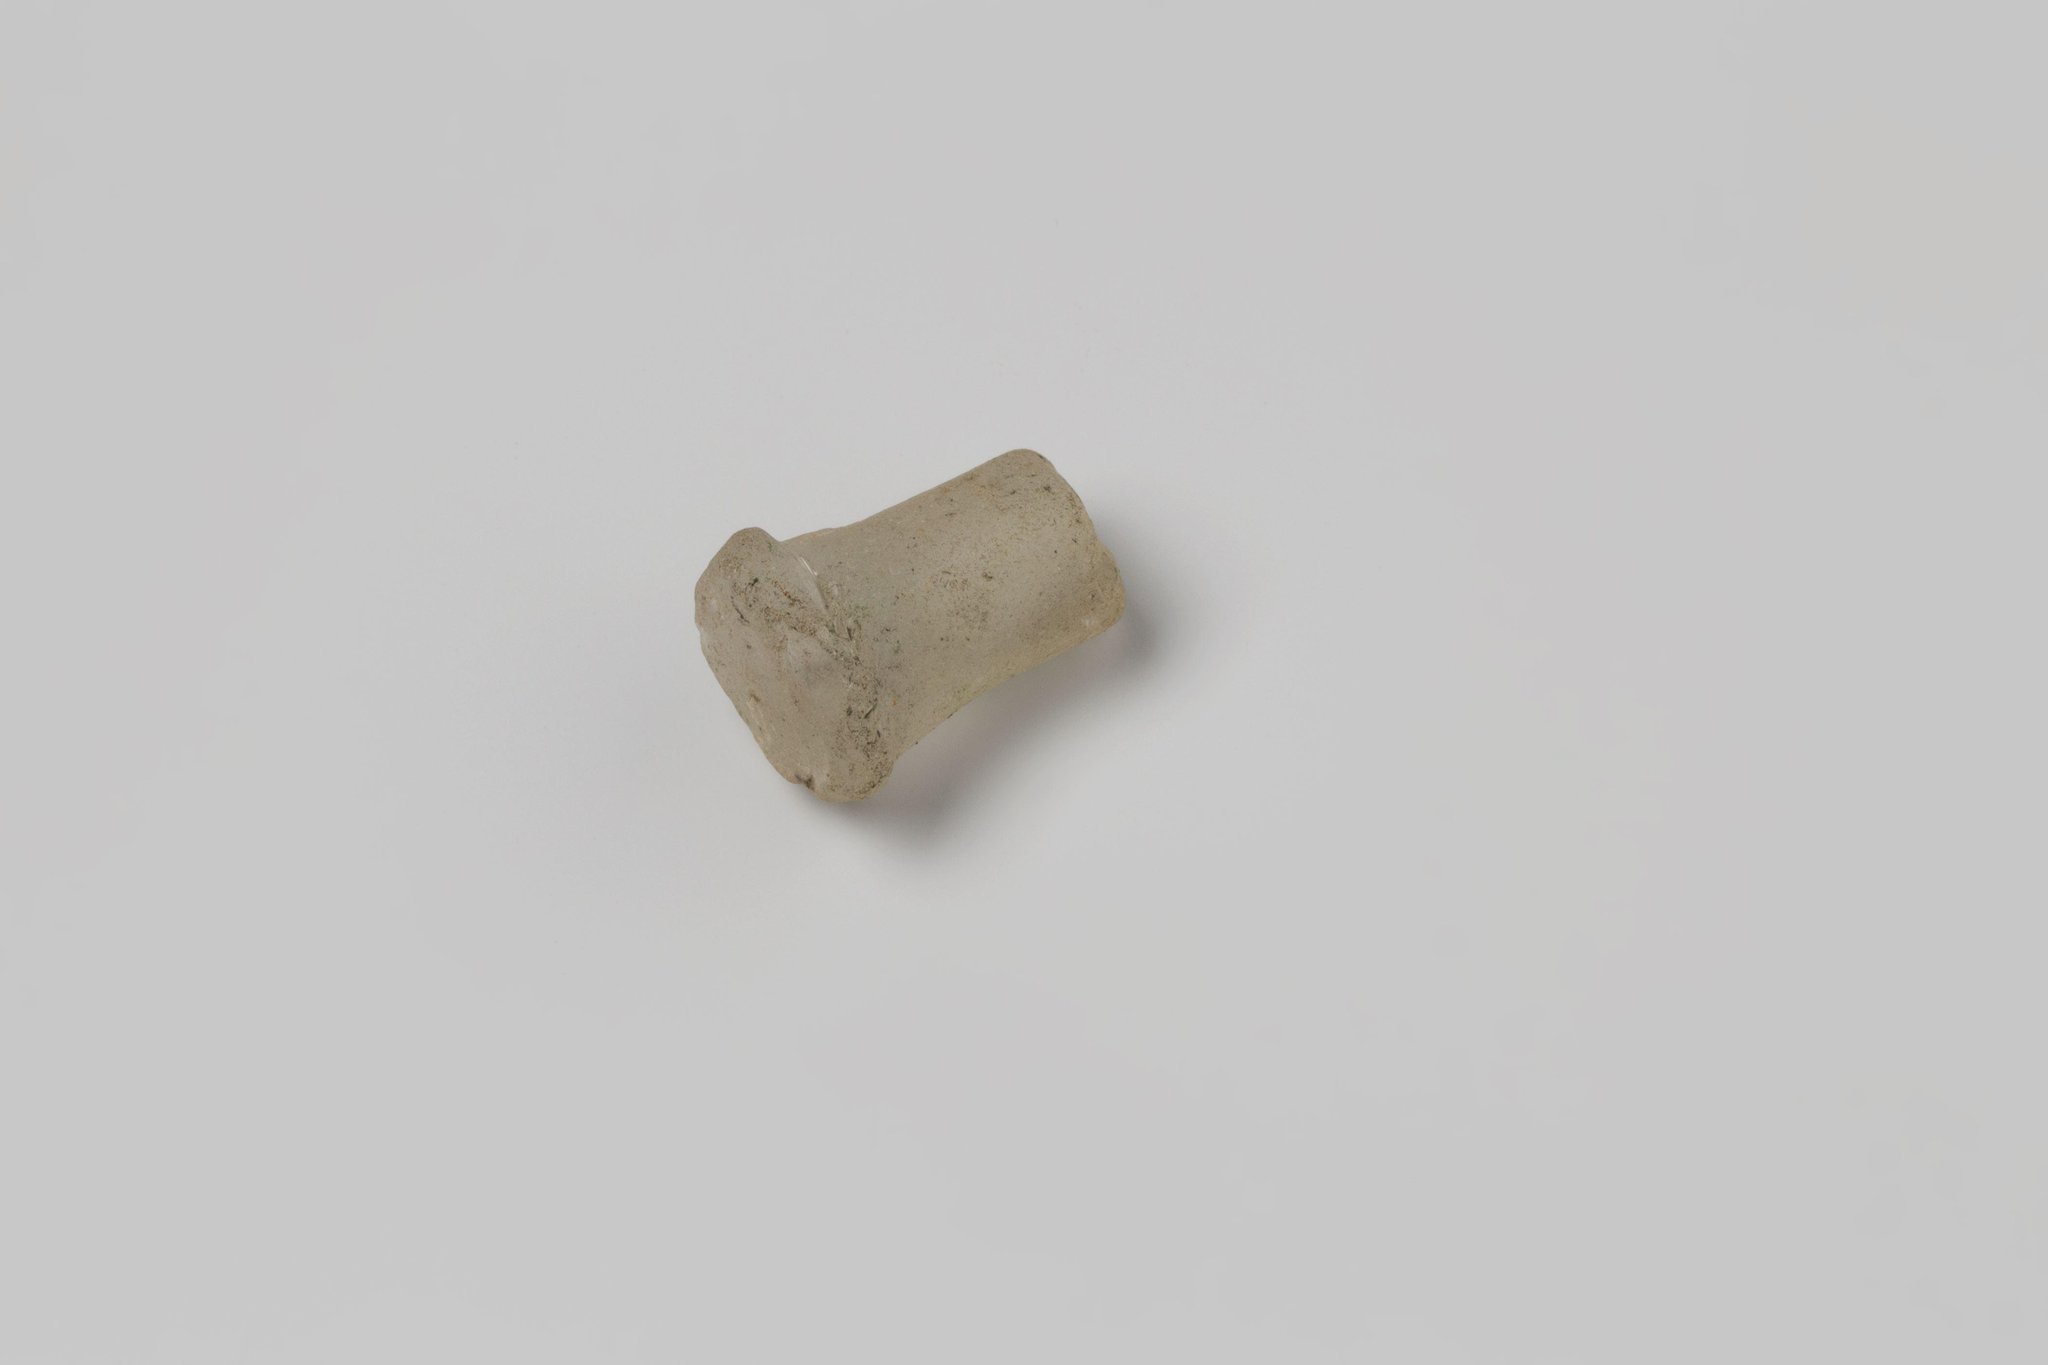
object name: helve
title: Fragment rechte steel van glas uit het wrak van de Oost-Indiëvaarder Hollandia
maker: Anonymous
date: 1700-1743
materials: glass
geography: netherlands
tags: verenigde oostindische compagnie, hollandia (schip), annet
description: Glass, stem glass, stems, plain; fragm, sim. NG 1980-27H750.